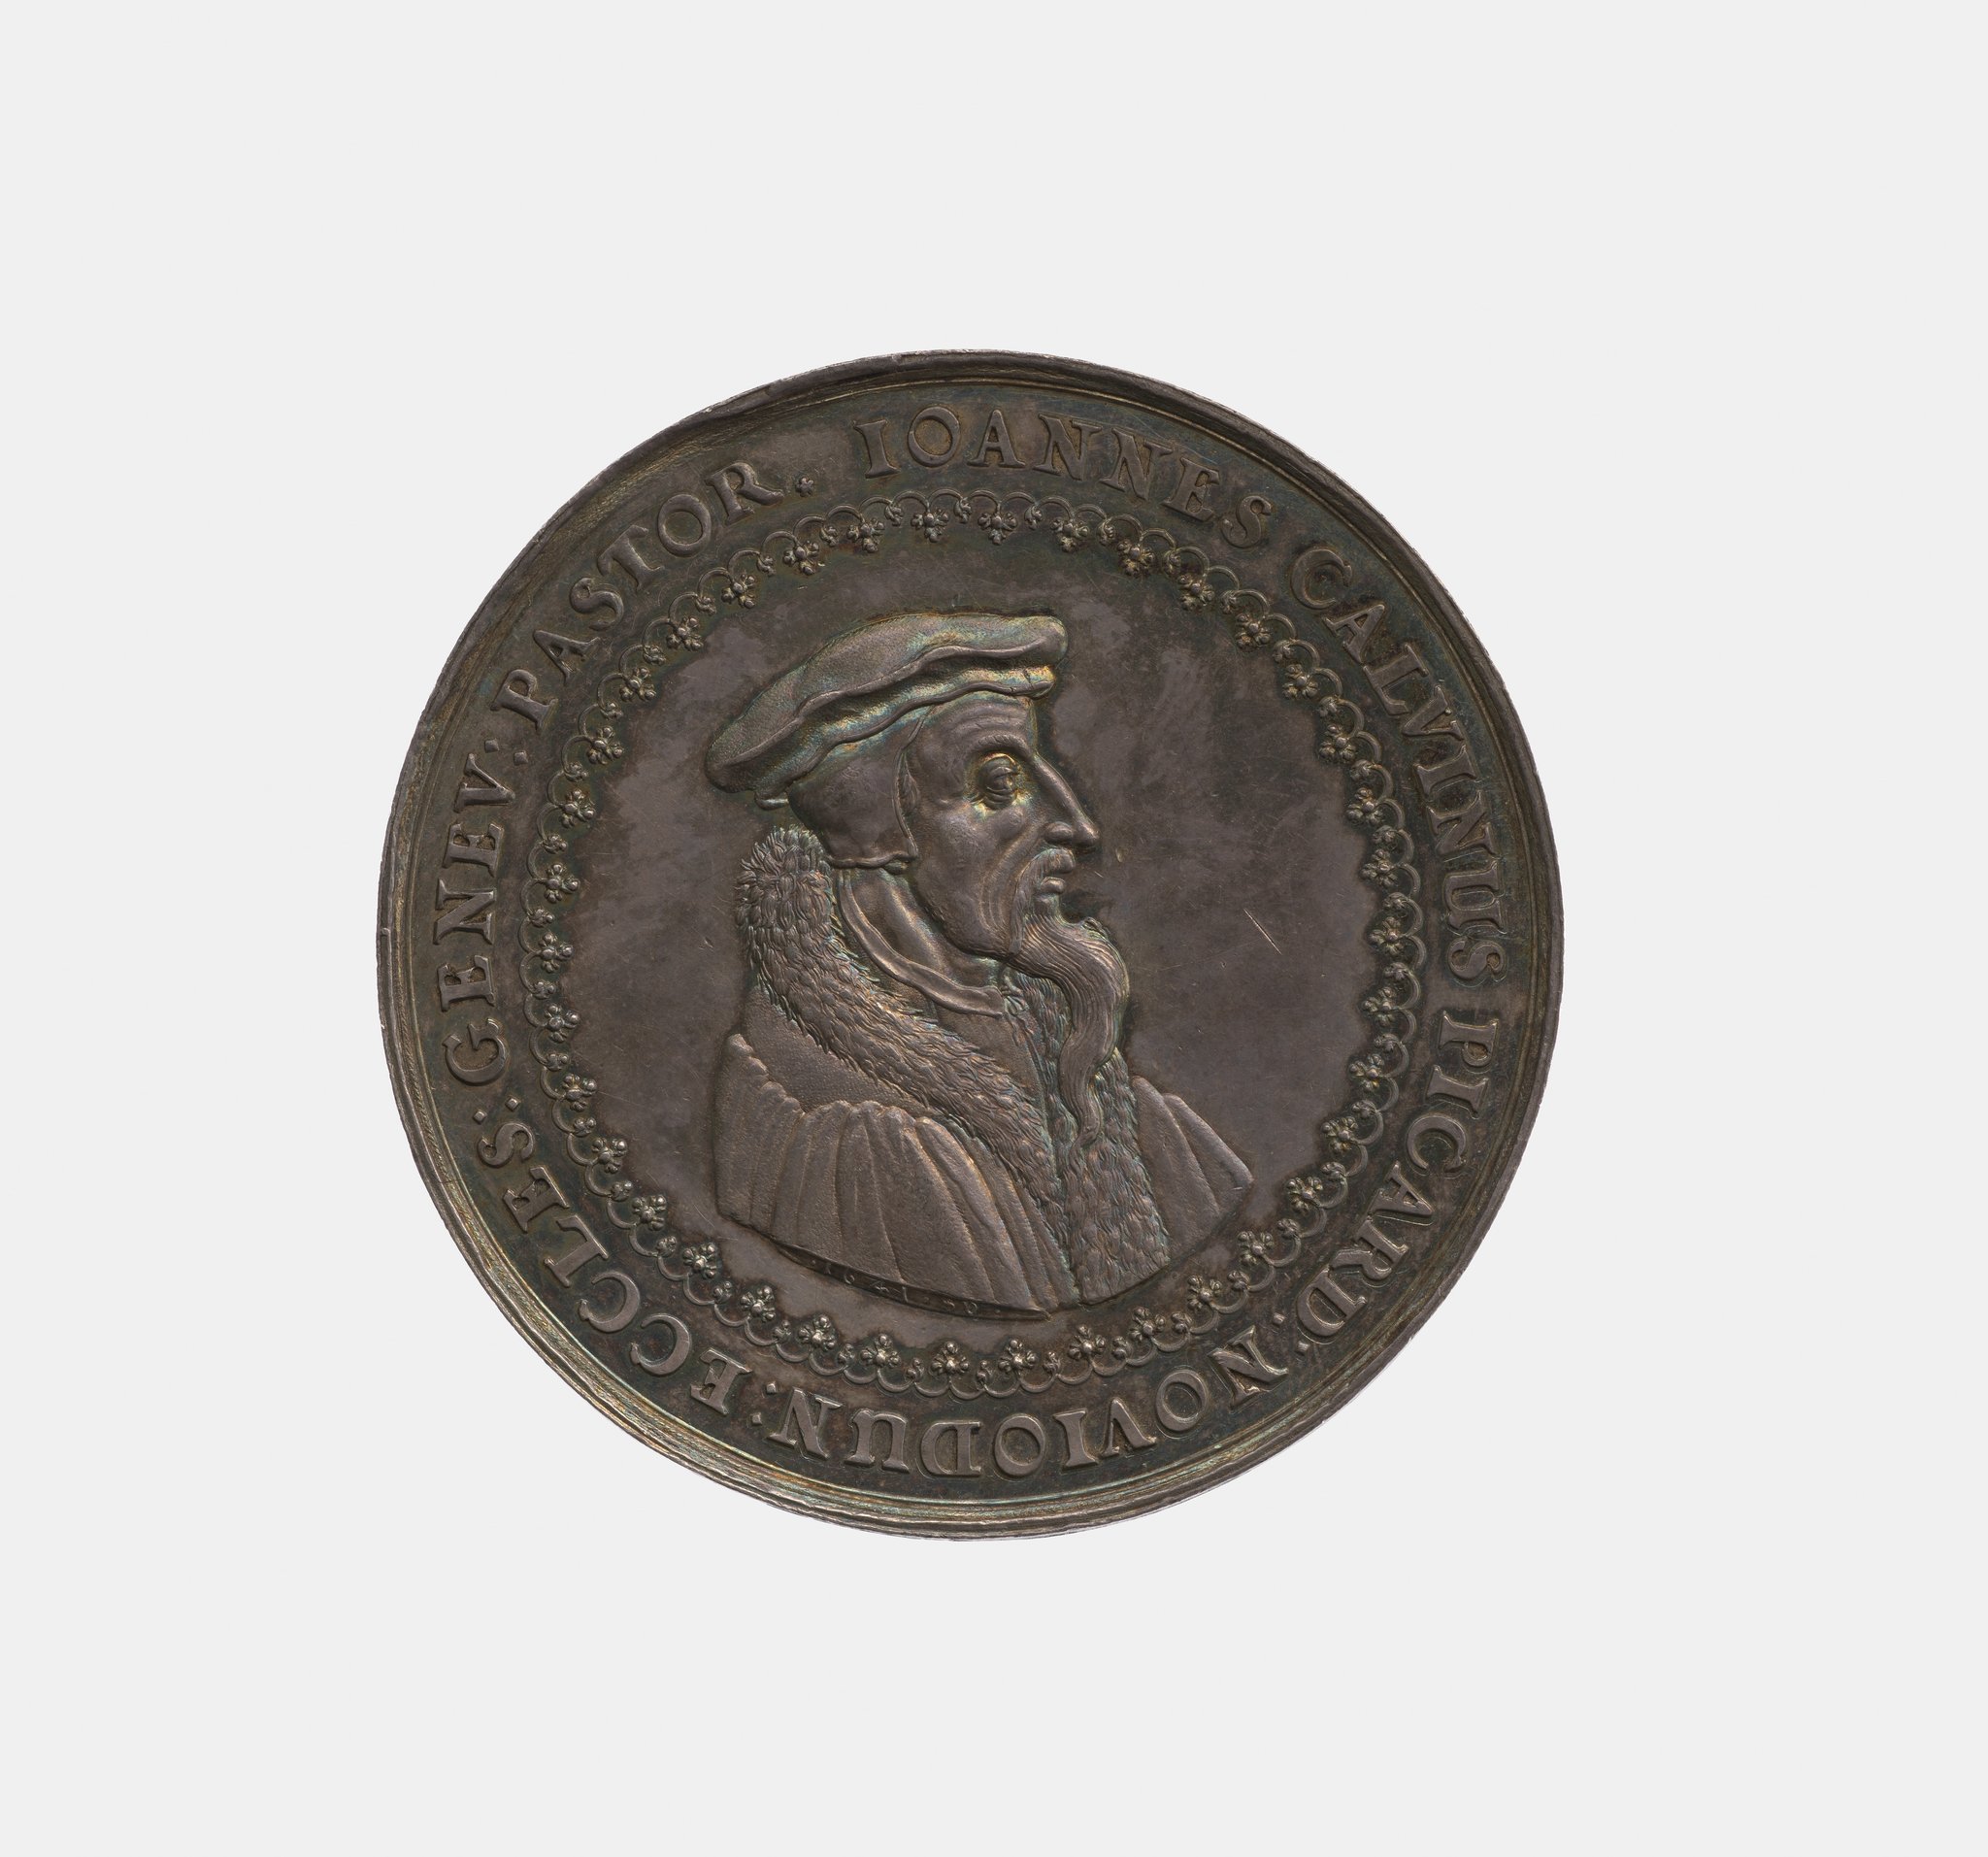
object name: medal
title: John Calvin (1509–1564)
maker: sebastian dadler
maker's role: artist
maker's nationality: german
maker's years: 1586-1657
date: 1641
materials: silver